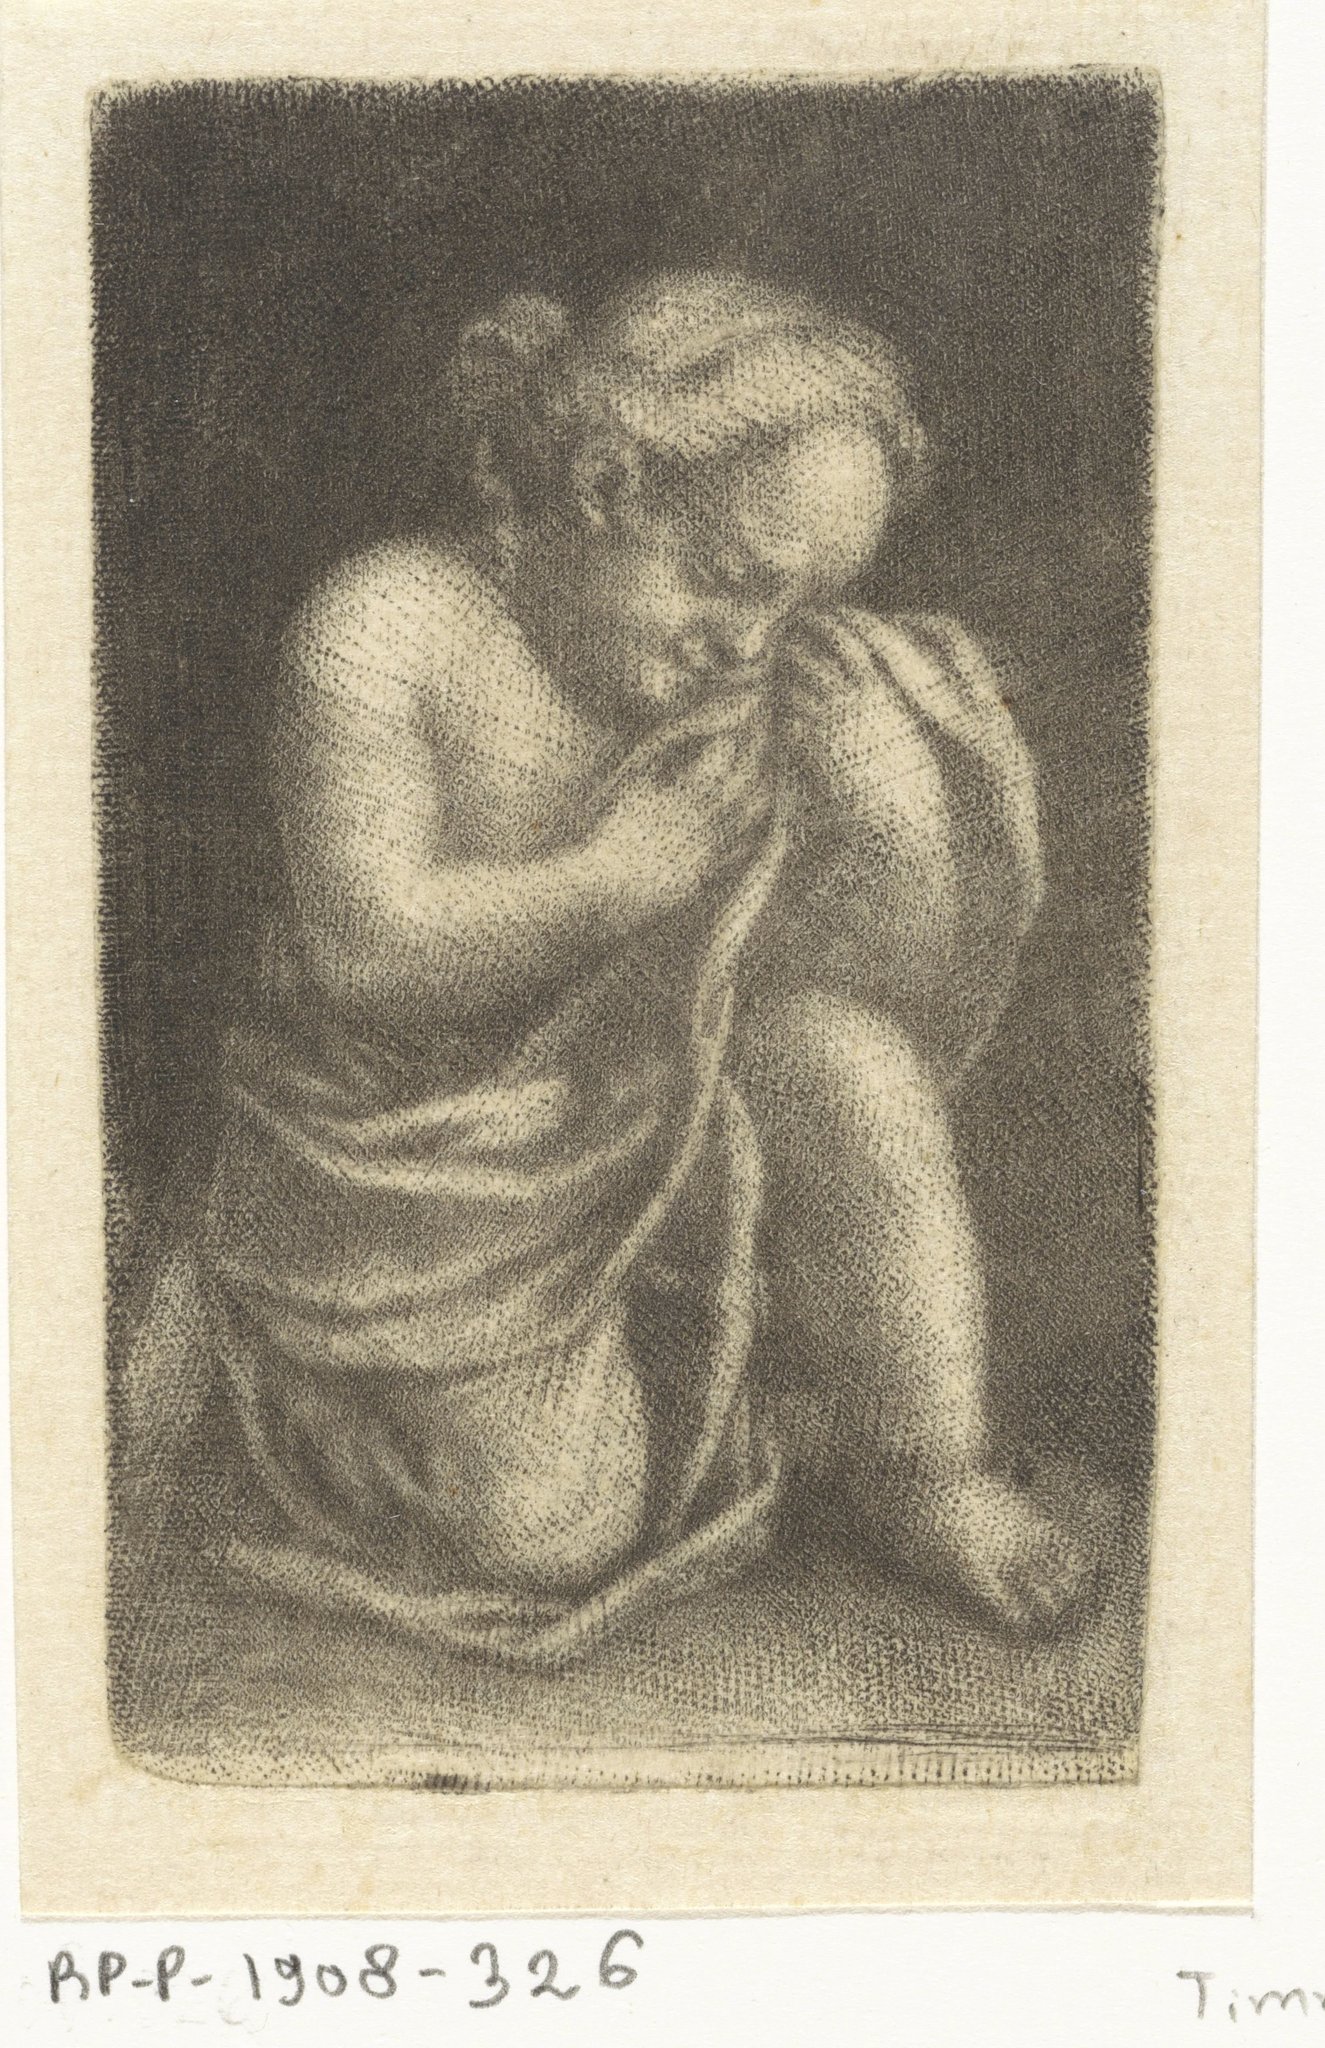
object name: print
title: Huilend kind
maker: gerard de lairesse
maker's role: draughtsman, painter, print maker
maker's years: 1641-1711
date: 1670-1680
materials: paper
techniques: mezzotint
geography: amsterdam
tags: child, crying, shouting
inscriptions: collector's mark: Lugt 2228